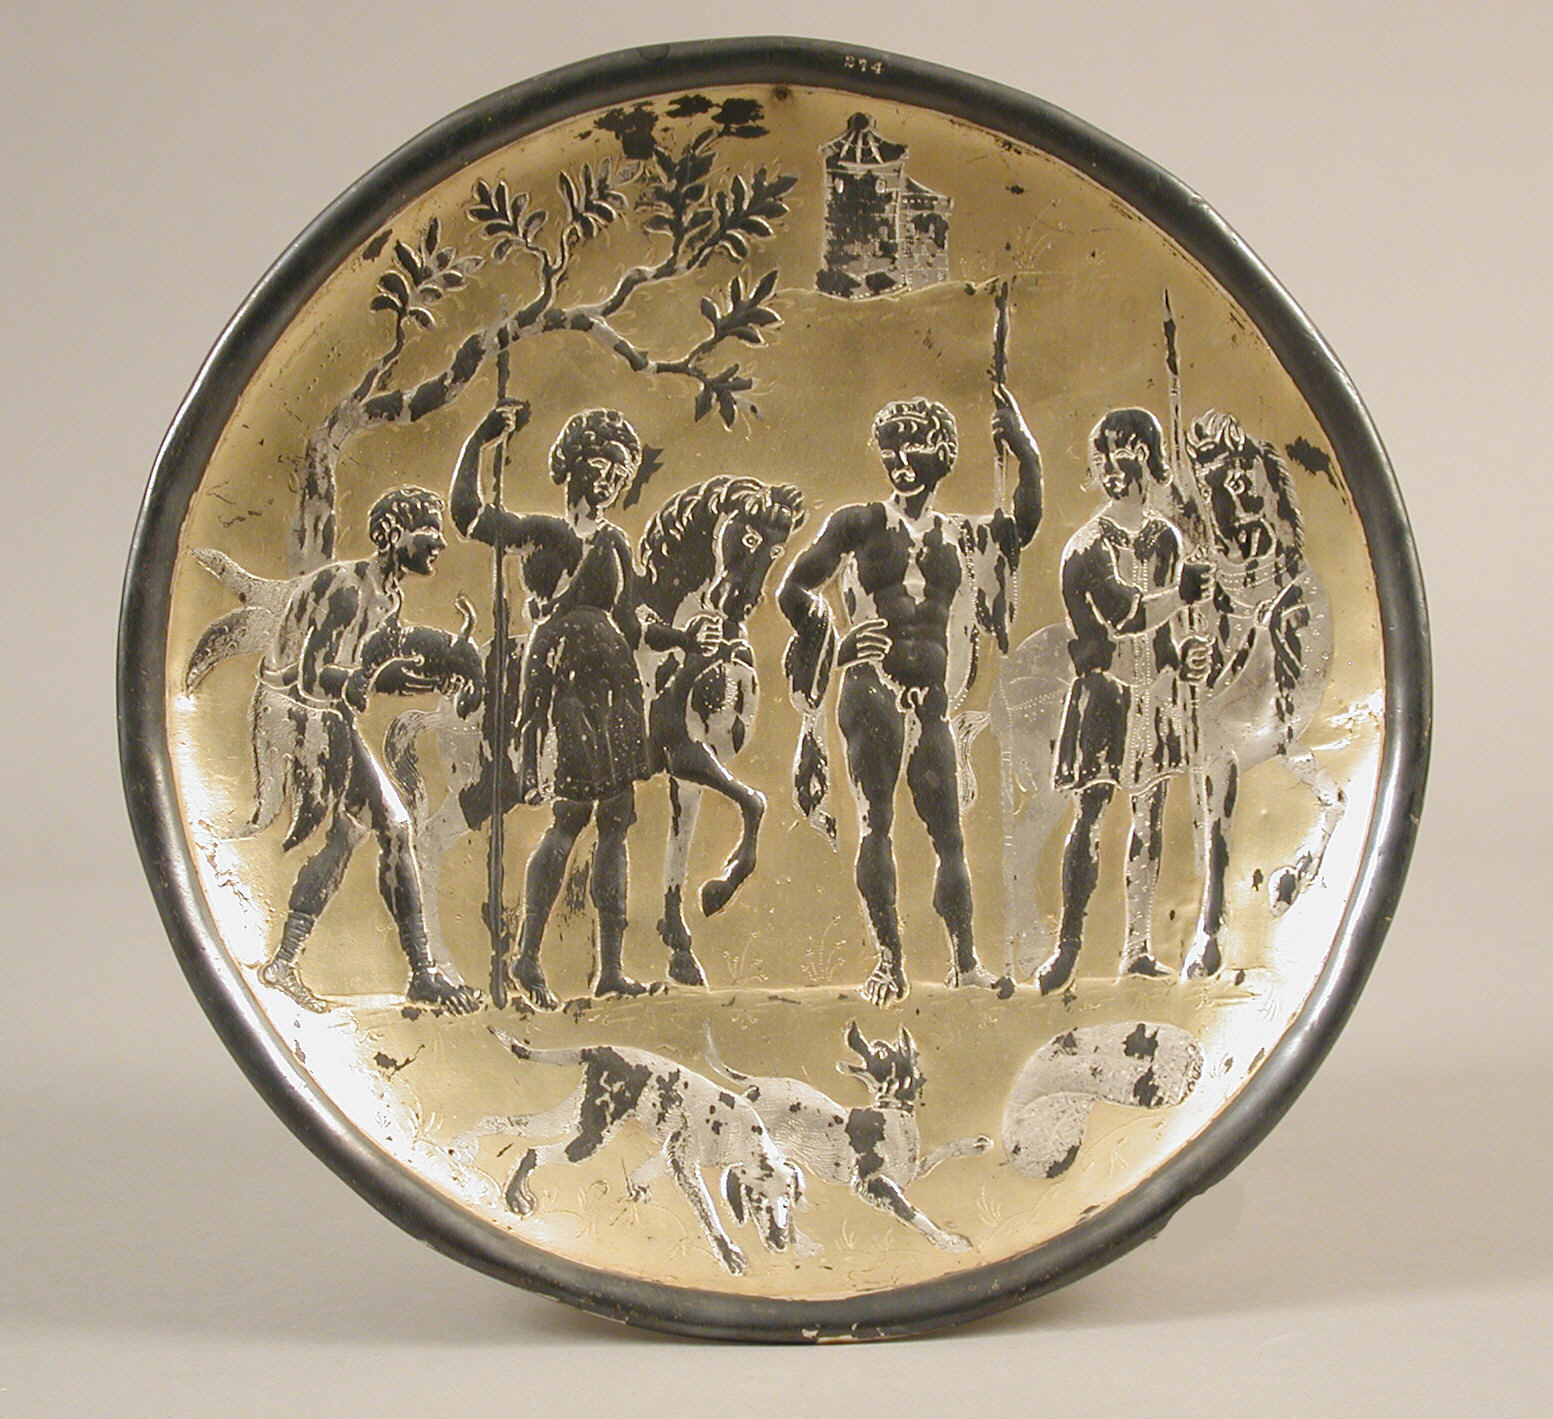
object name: plate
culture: byzantine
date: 1801-1900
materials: silver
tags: animals,male nudes,women